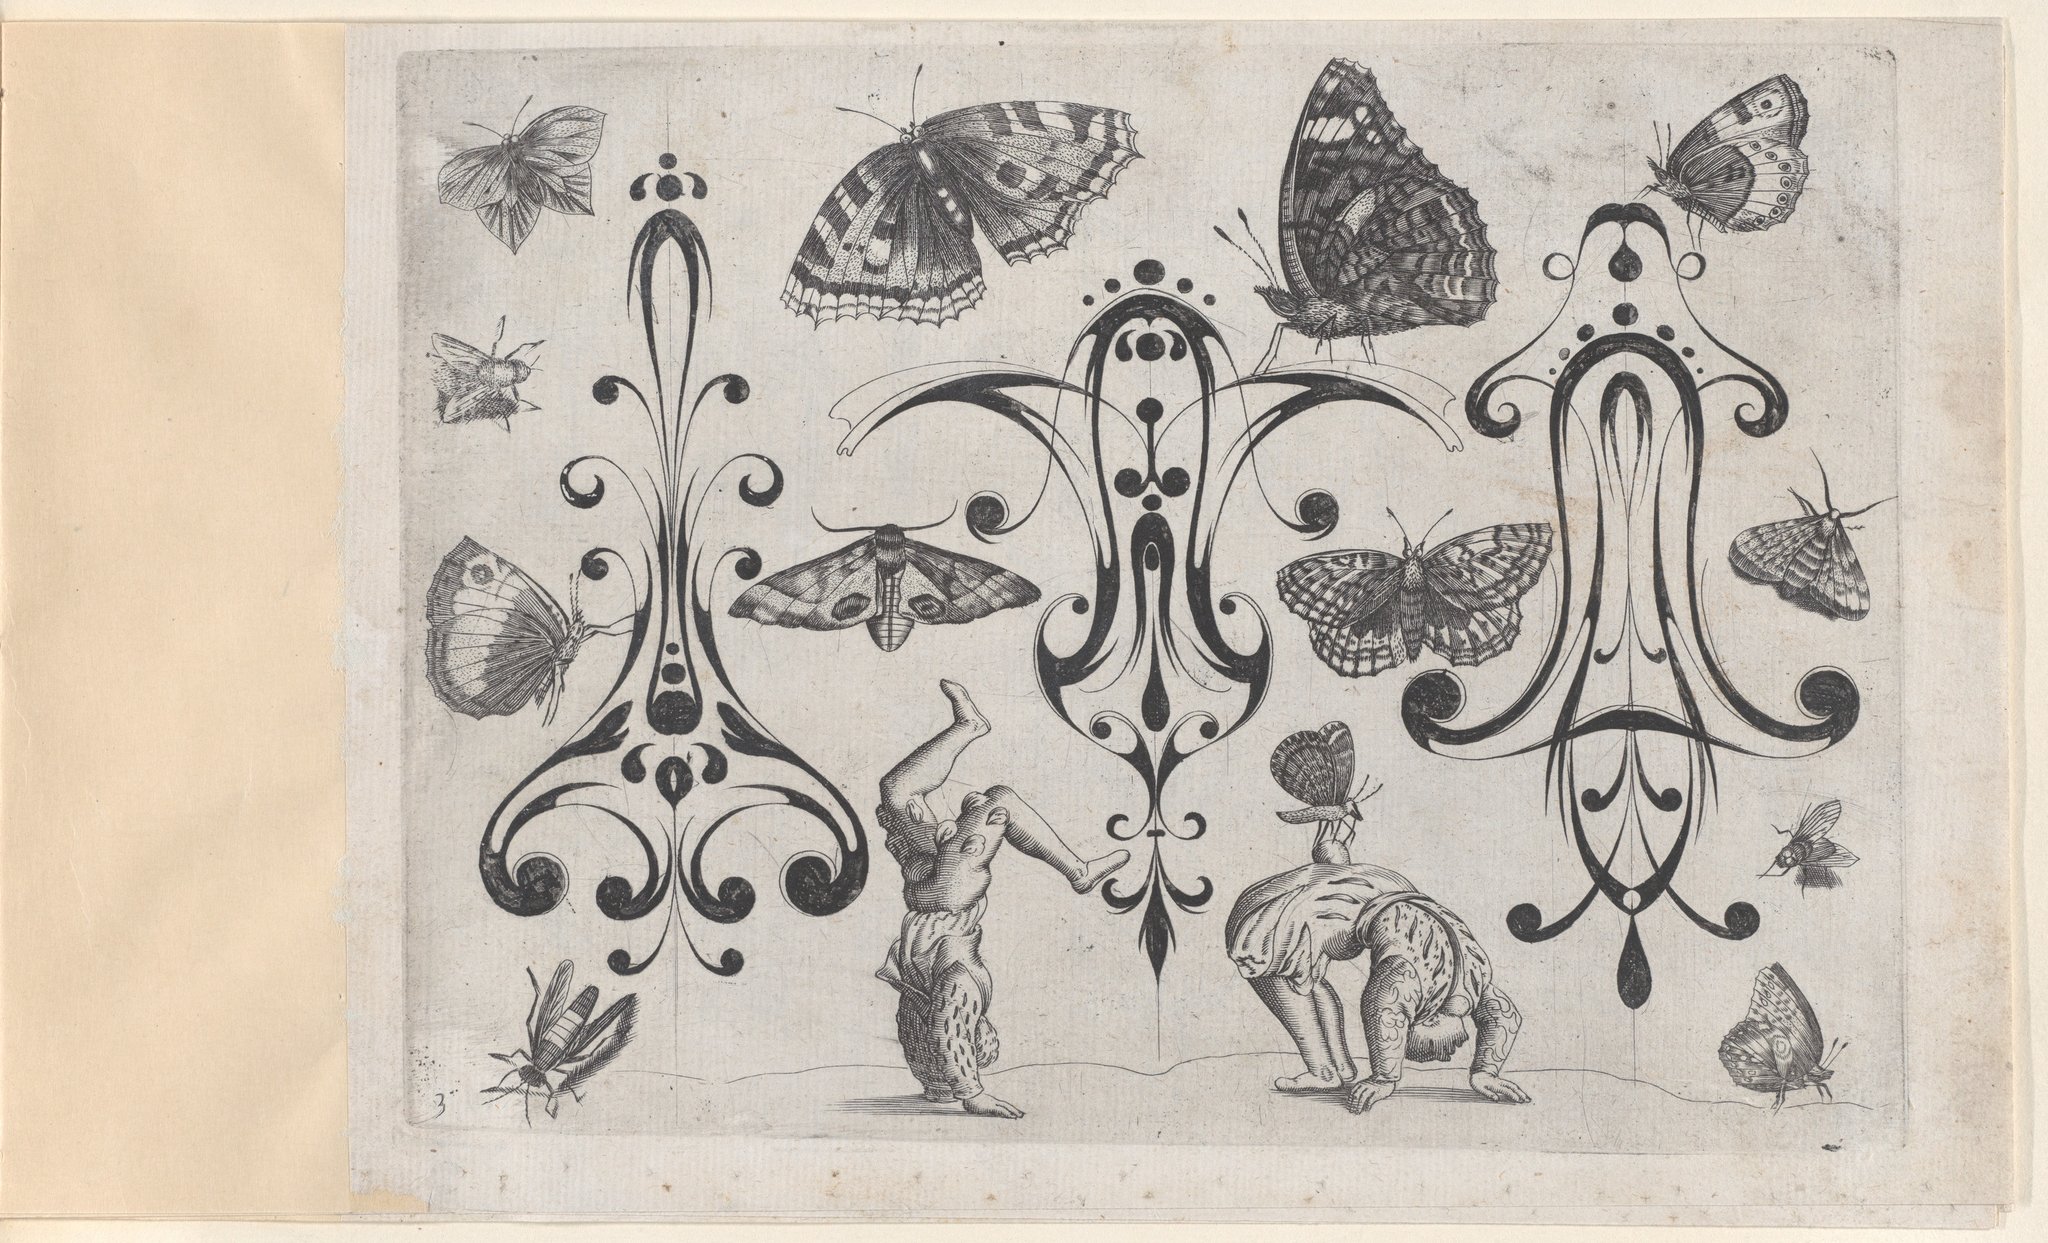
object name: album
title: Blackwork Designs with Acrobats, Butterflies and Other Insects, Plate 3 from a Series of Blackwork Ornaments combined with Figures, Birds, Animals and Flowers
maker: meinert gelijs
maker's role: artist and engraver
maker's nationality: dutch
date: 1622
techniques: embroidery, engraving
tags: ornament,insects,butterflies,acrobats